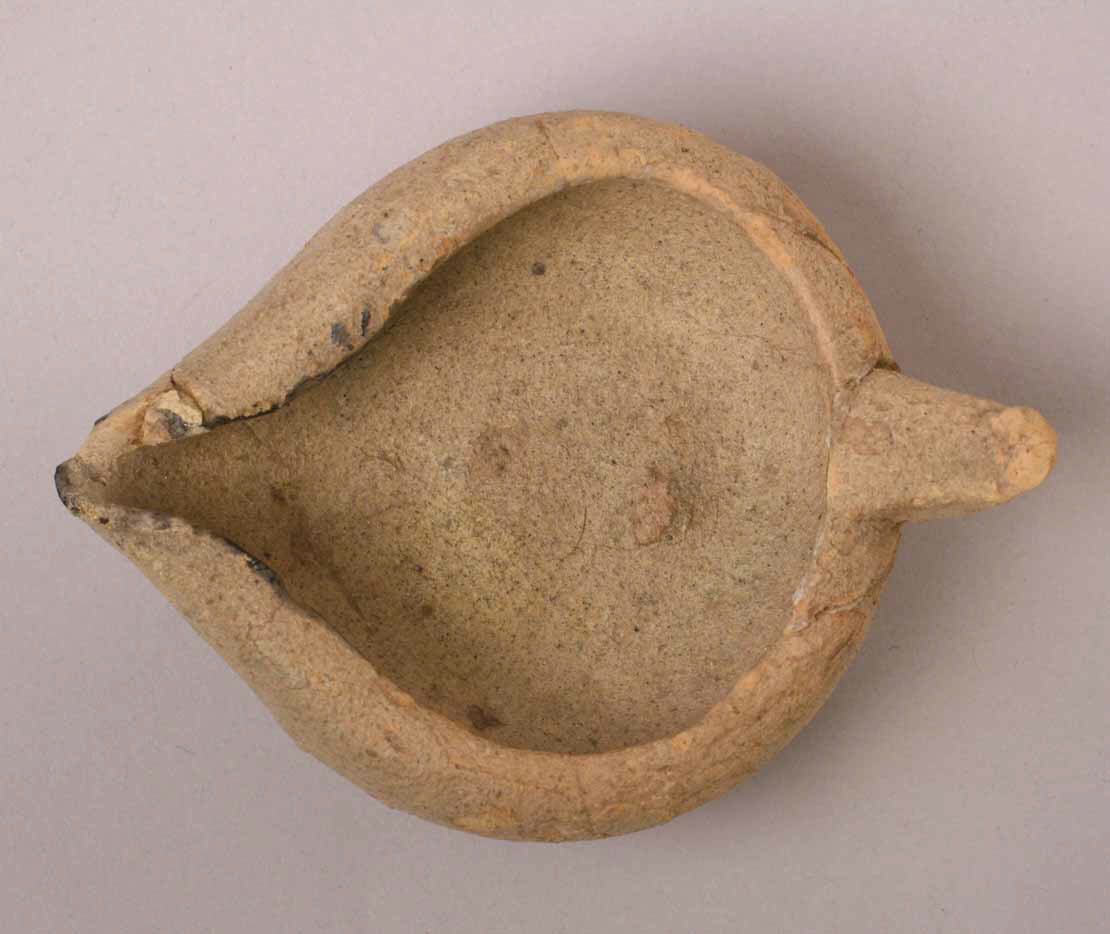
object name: lamp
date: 801-1100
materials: earthenware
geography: iran